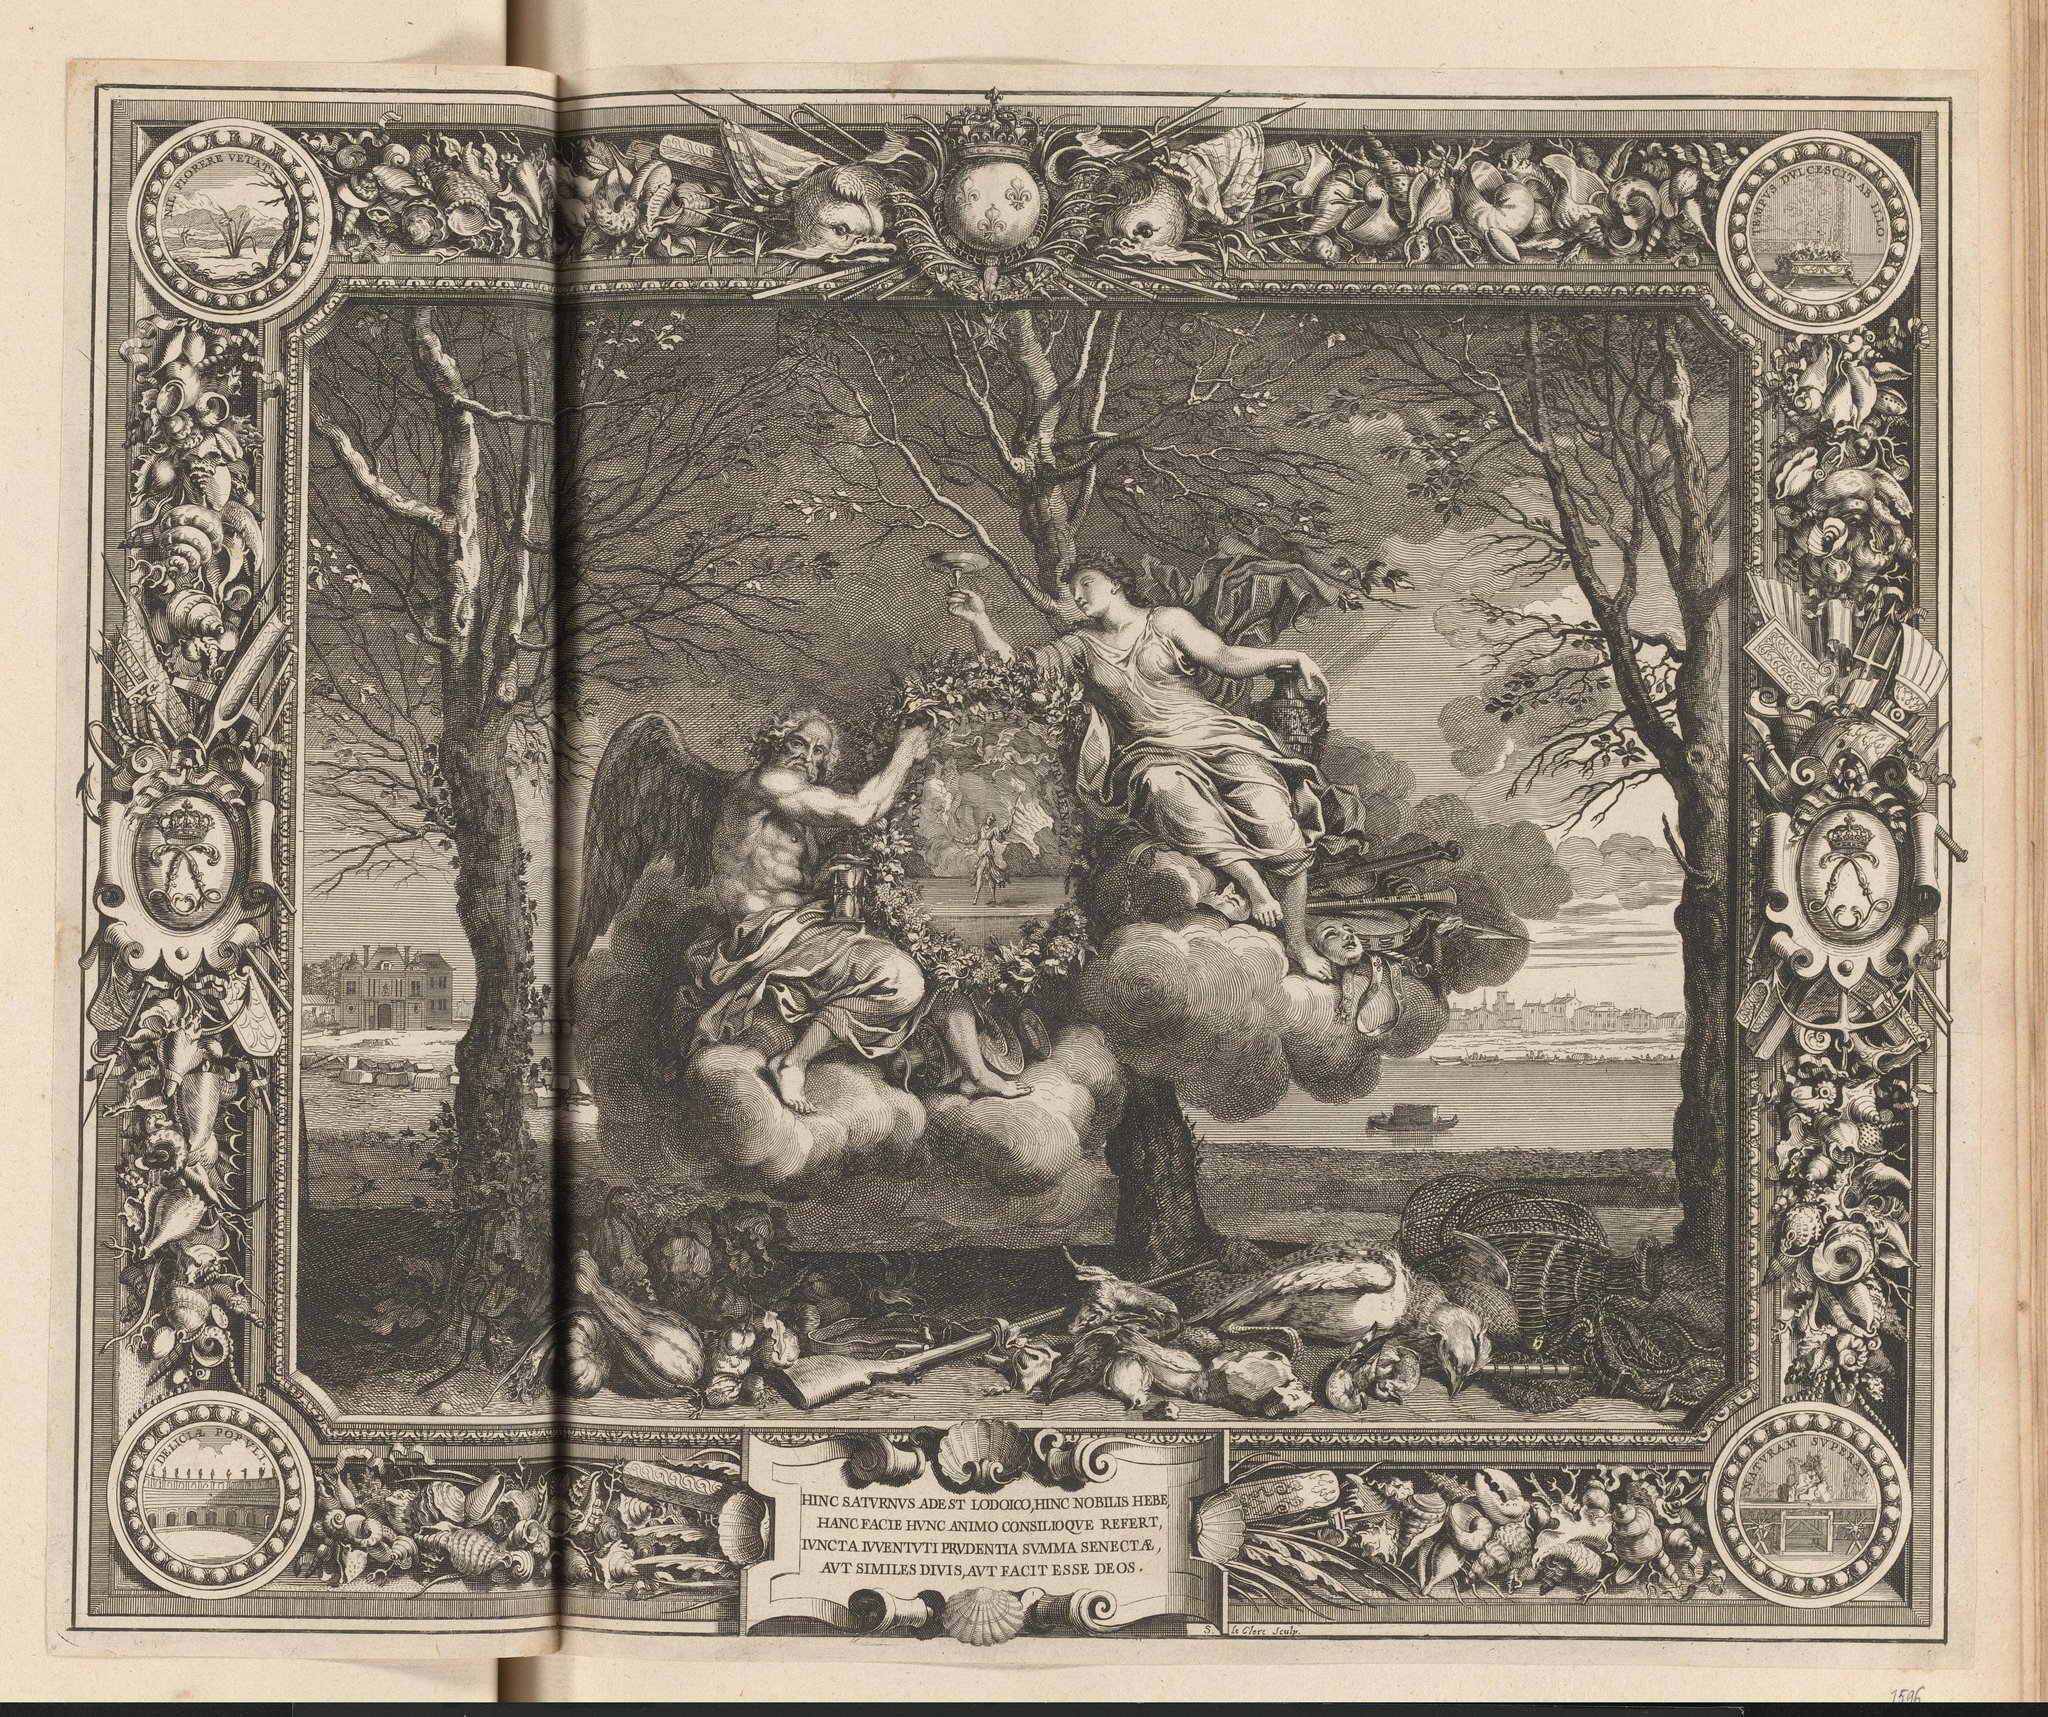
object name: print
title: Allegorie op de winter, in een cartouche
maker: sébastien leclerc (i)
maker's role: print maker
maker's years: 1637-1714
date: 1670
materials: paper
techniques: engraving, etching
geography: paris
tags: (story of) saturn (cronus), winter, 'hyems'; 'inverno' (ripa), medea, (story of) hebe (juventas), scallop, shell ~ ornament, father time, man with wings and scythe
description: Saturnus en Hebe op een wolk, met tussen hen in een medaillon met Medea. Als omlijsting een ornamentele cartouche met objecten gerelateerd aan het element water. Prent maakt deel uit van een album.